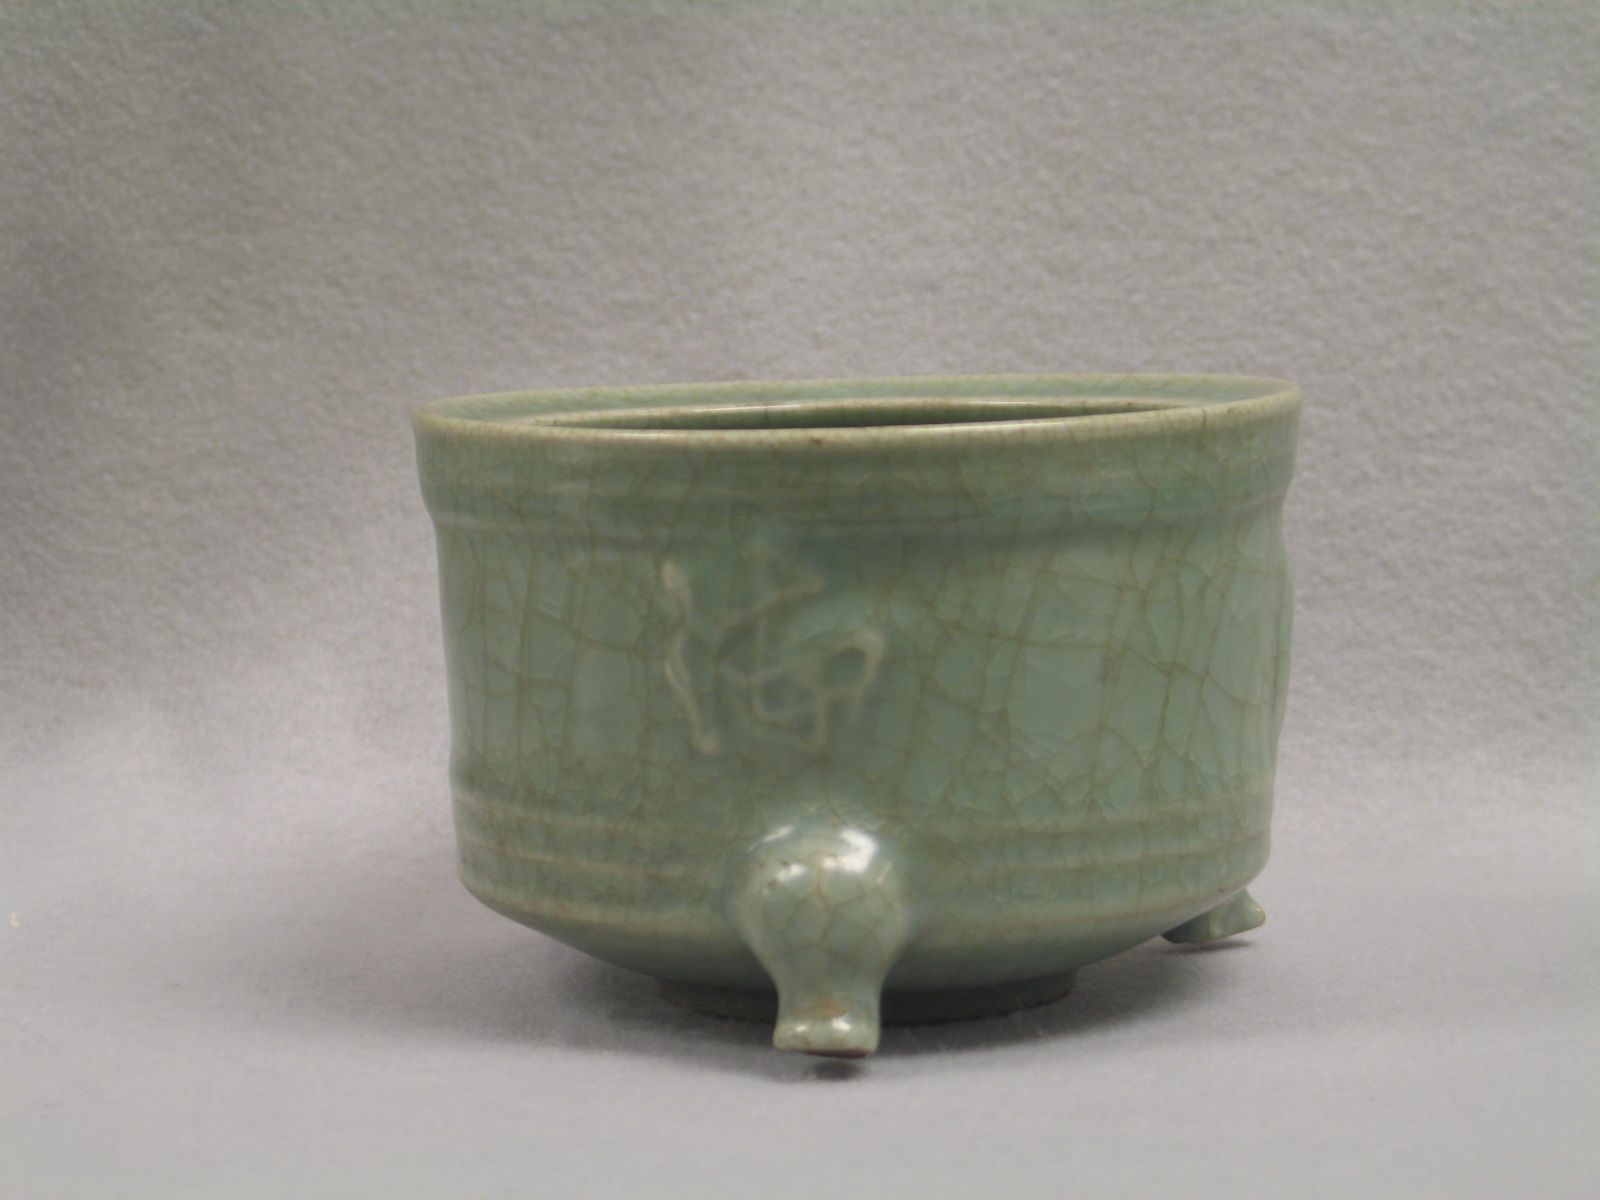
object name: incense burner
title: Incense burner with characters "longevity, mountain, fortune, sea" (shou shan fu hai)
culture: chinese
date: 1201-1300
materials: ceramic glaze, glaze, stoneware